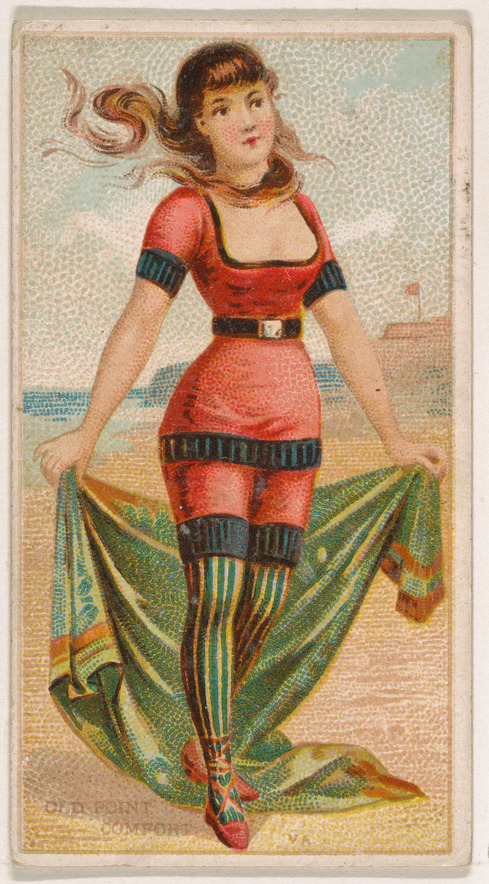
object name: print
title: Old Point Comfort, Virginia, from the Surf Beauties series (N232), issued by Kinney Bros.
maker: kinney brothers tobacco company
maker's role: publisher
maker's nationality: american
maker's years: 1869-2011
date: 1889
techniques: color lithograph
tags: women